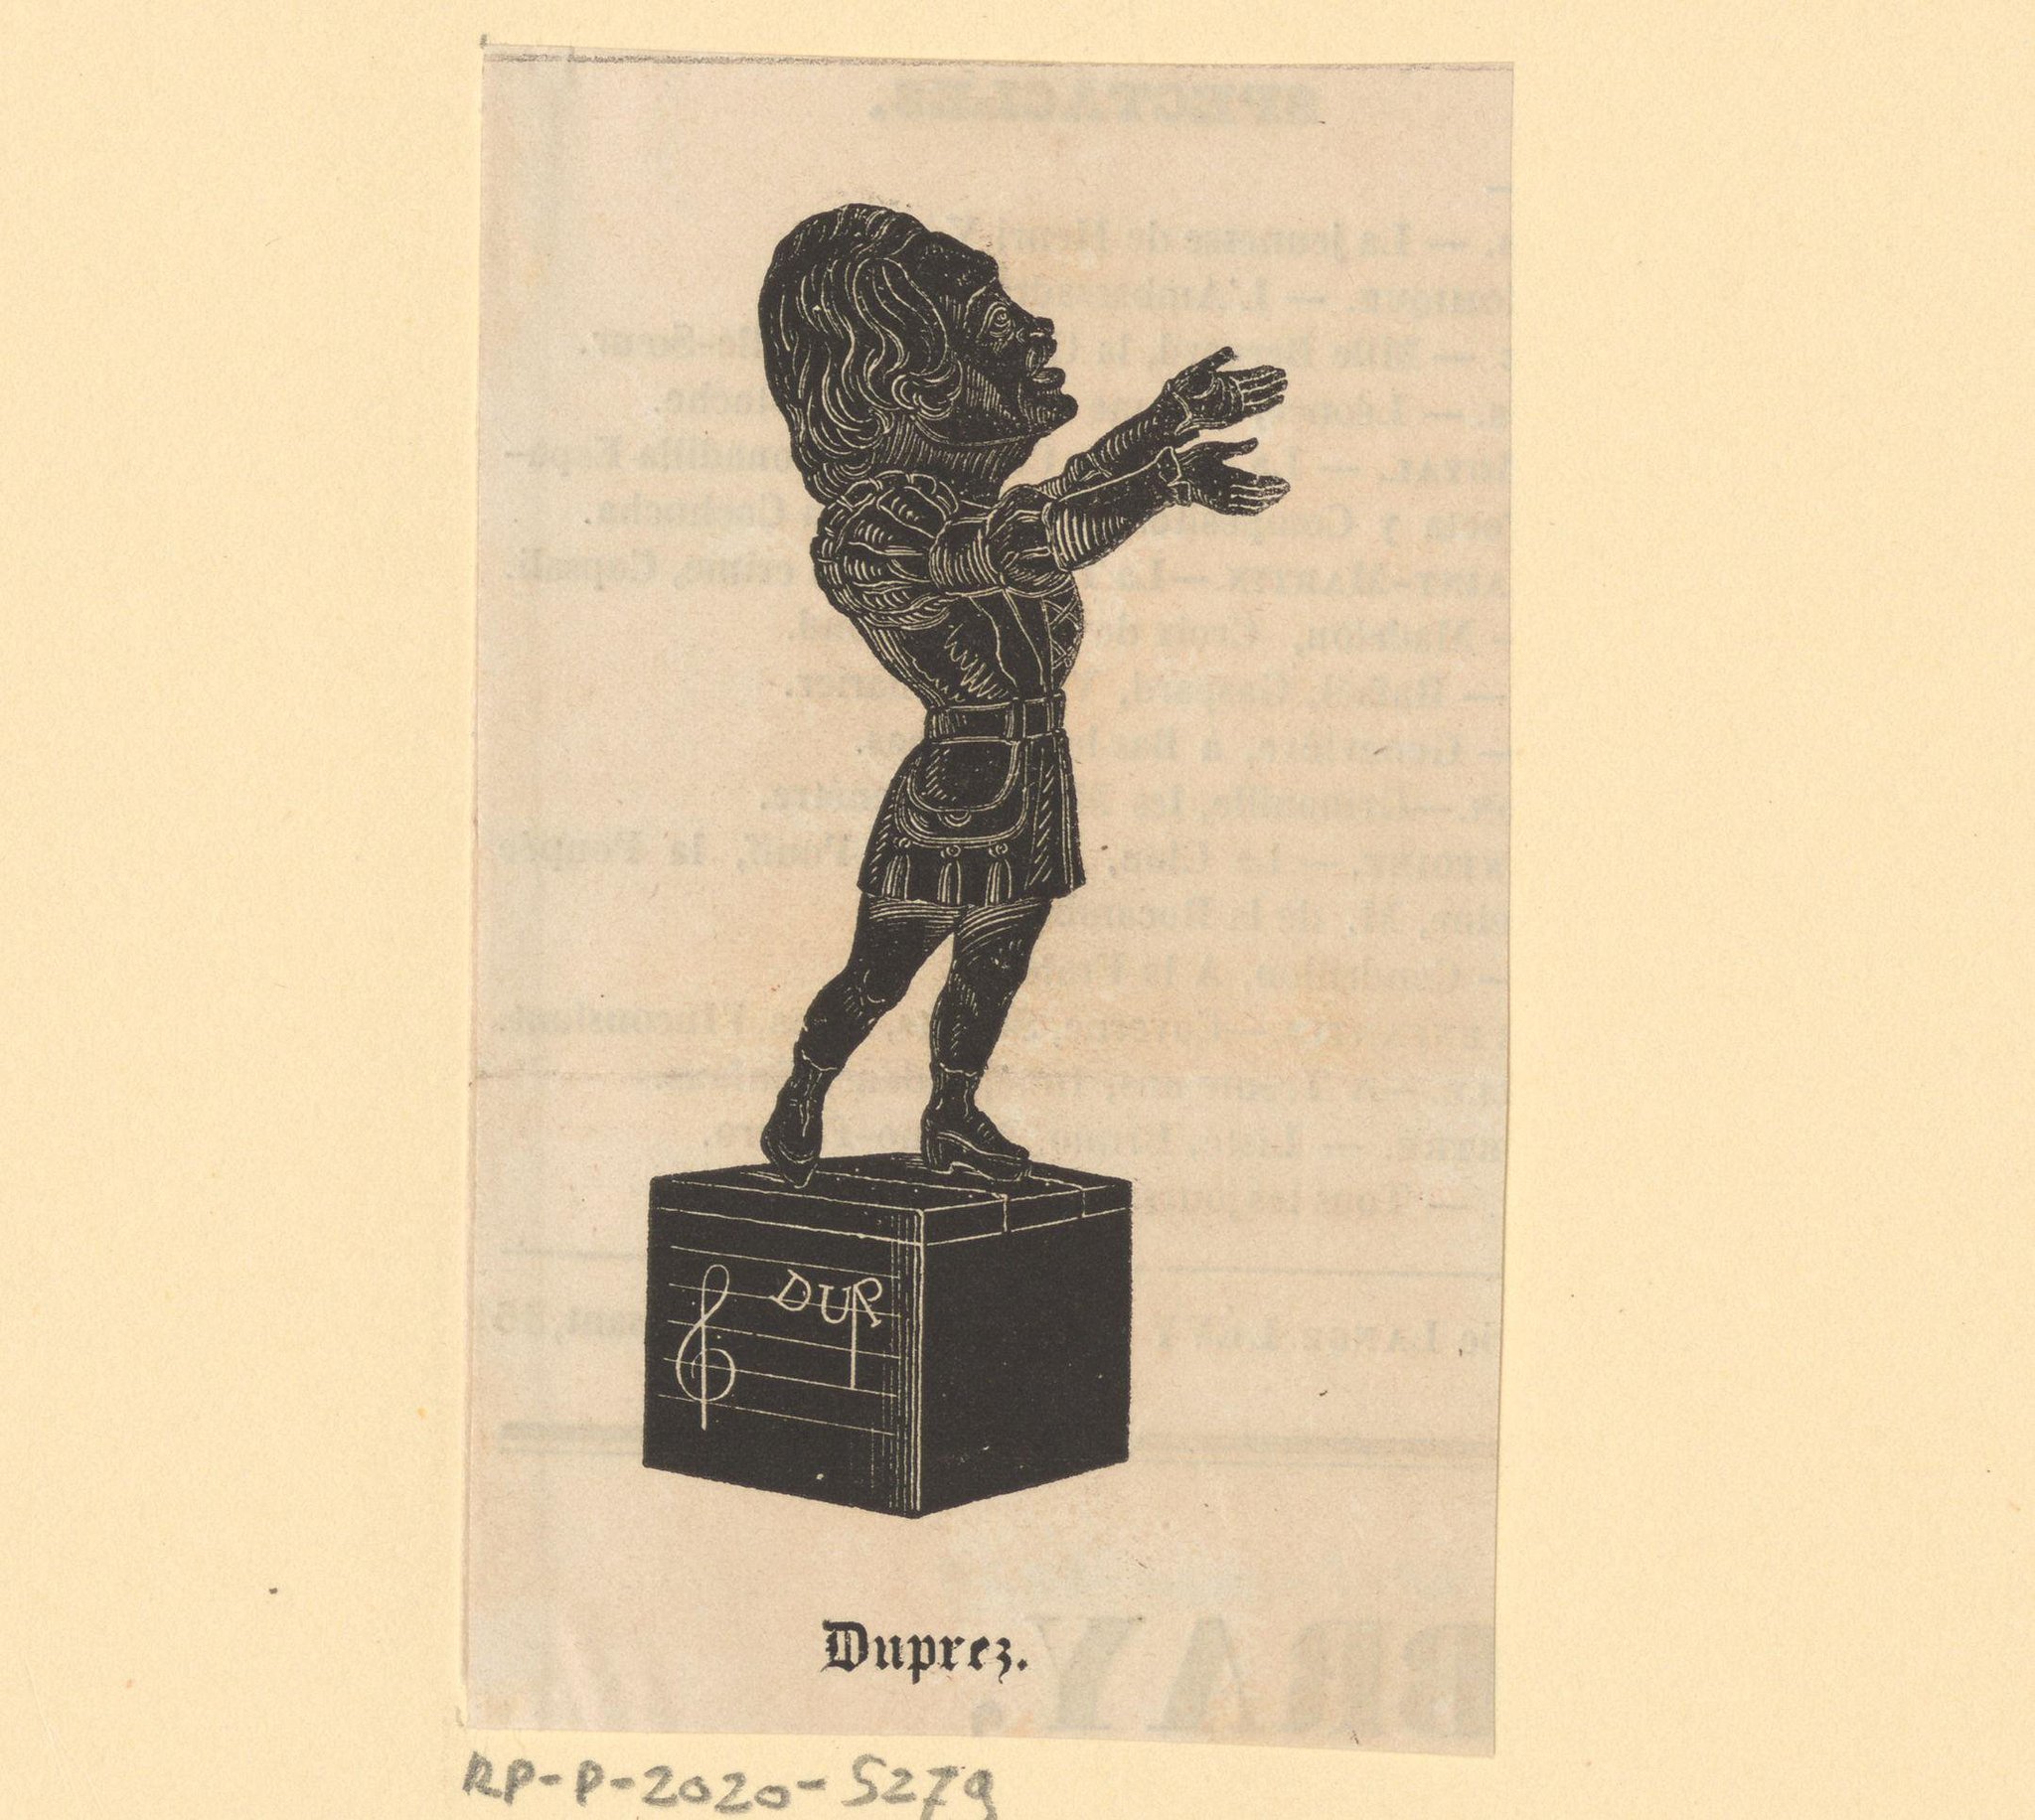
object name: print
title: Portret van Gilbert Duprez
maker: Anonymous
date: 1839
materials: paper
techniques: letterpress printing, engraving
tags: historical persons, portrait of opera-singer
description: Prent zonder tekst op verso gebruikt in: Musée Dantan. Galerie des charges et croquis des célébrités de l'époque (...). Parijs: Henri Delloye, 1839.